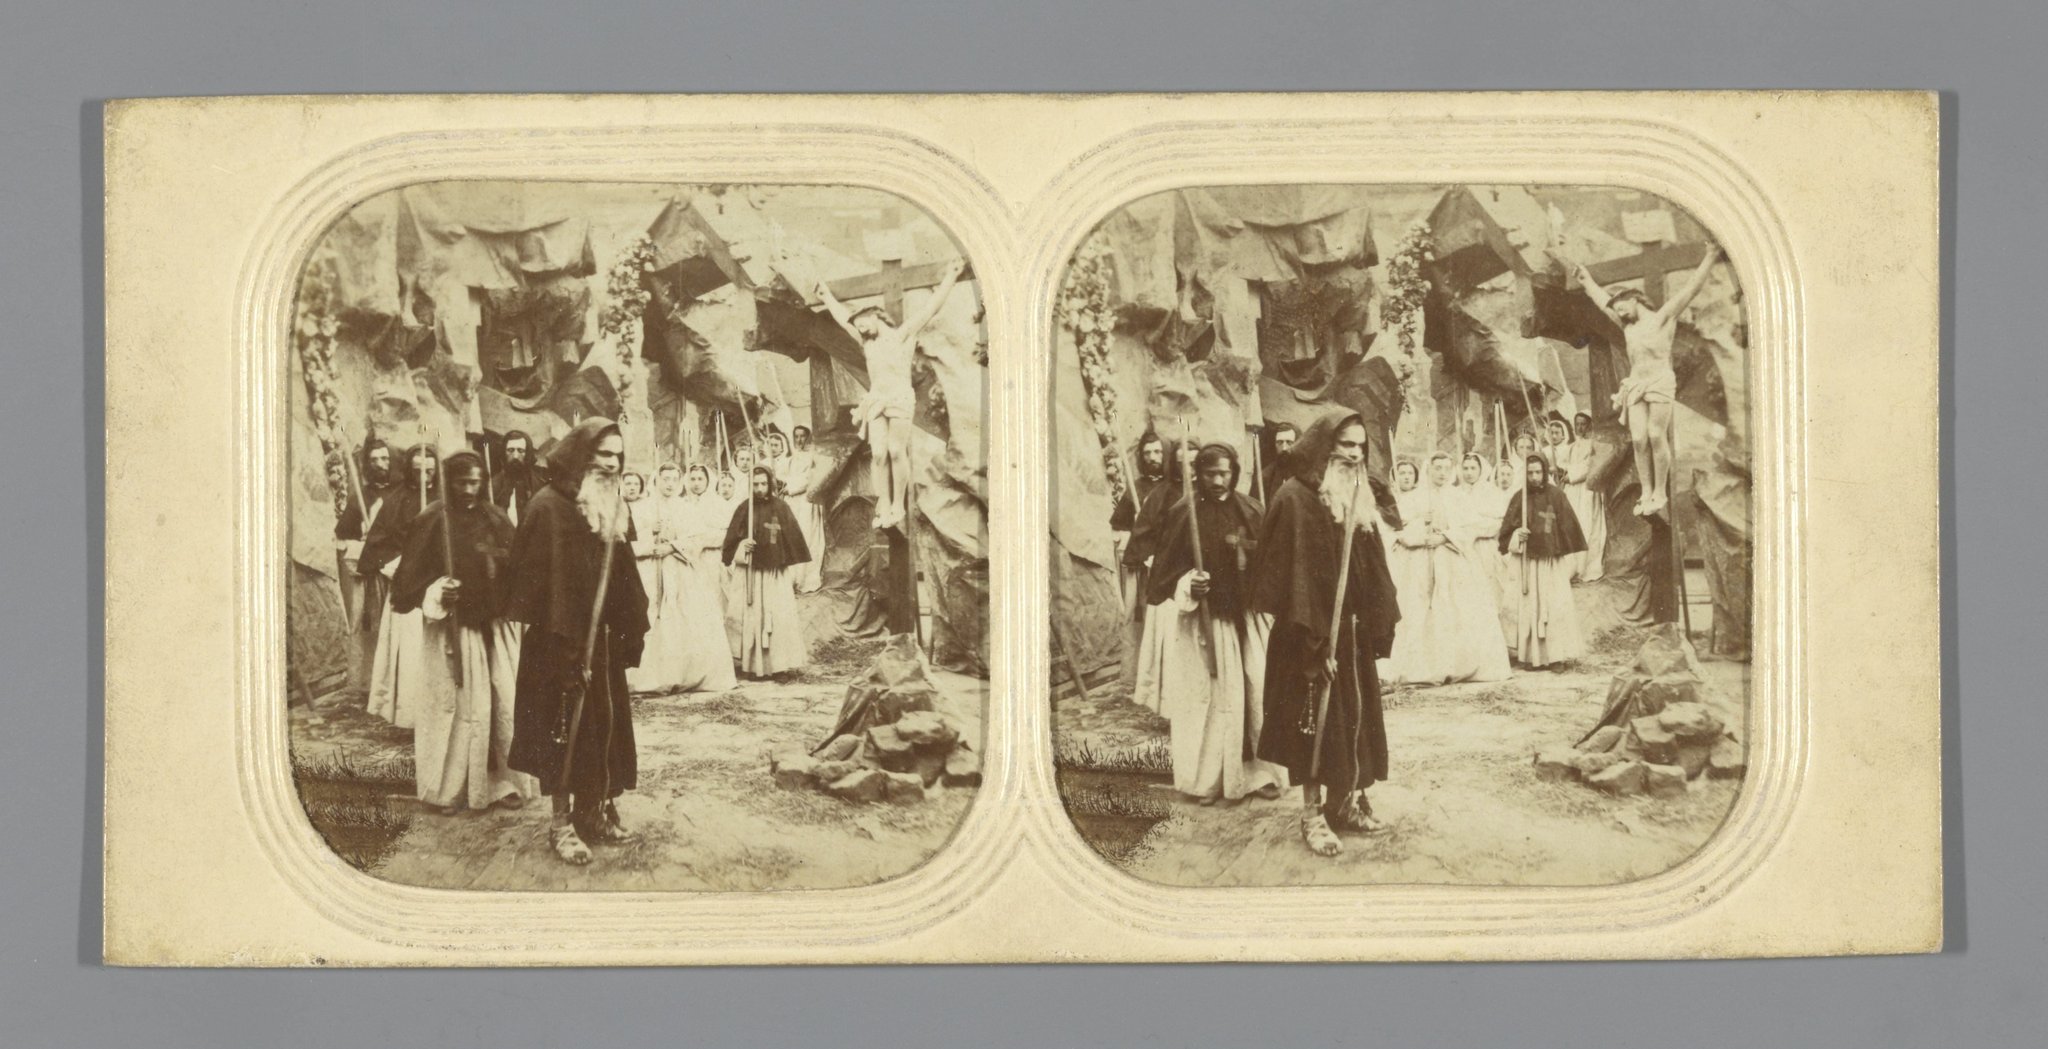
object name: tissue stereograph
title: Processie rond Christusbeeld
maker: Anonymous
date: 1855-1875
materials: cardboard, paper, photographic support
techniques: albumen print, cutting, hand coloring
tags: procession ~ christian religion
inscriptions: inscription: ‘H’, retailer's mark: ‘Kunsthandlung/ Joh. Heinrigs/ in/ Cöln/ Hochstrasse 152./ Liefert alle in Jn. und Auslande/ erachienenen Kunstblätter.’